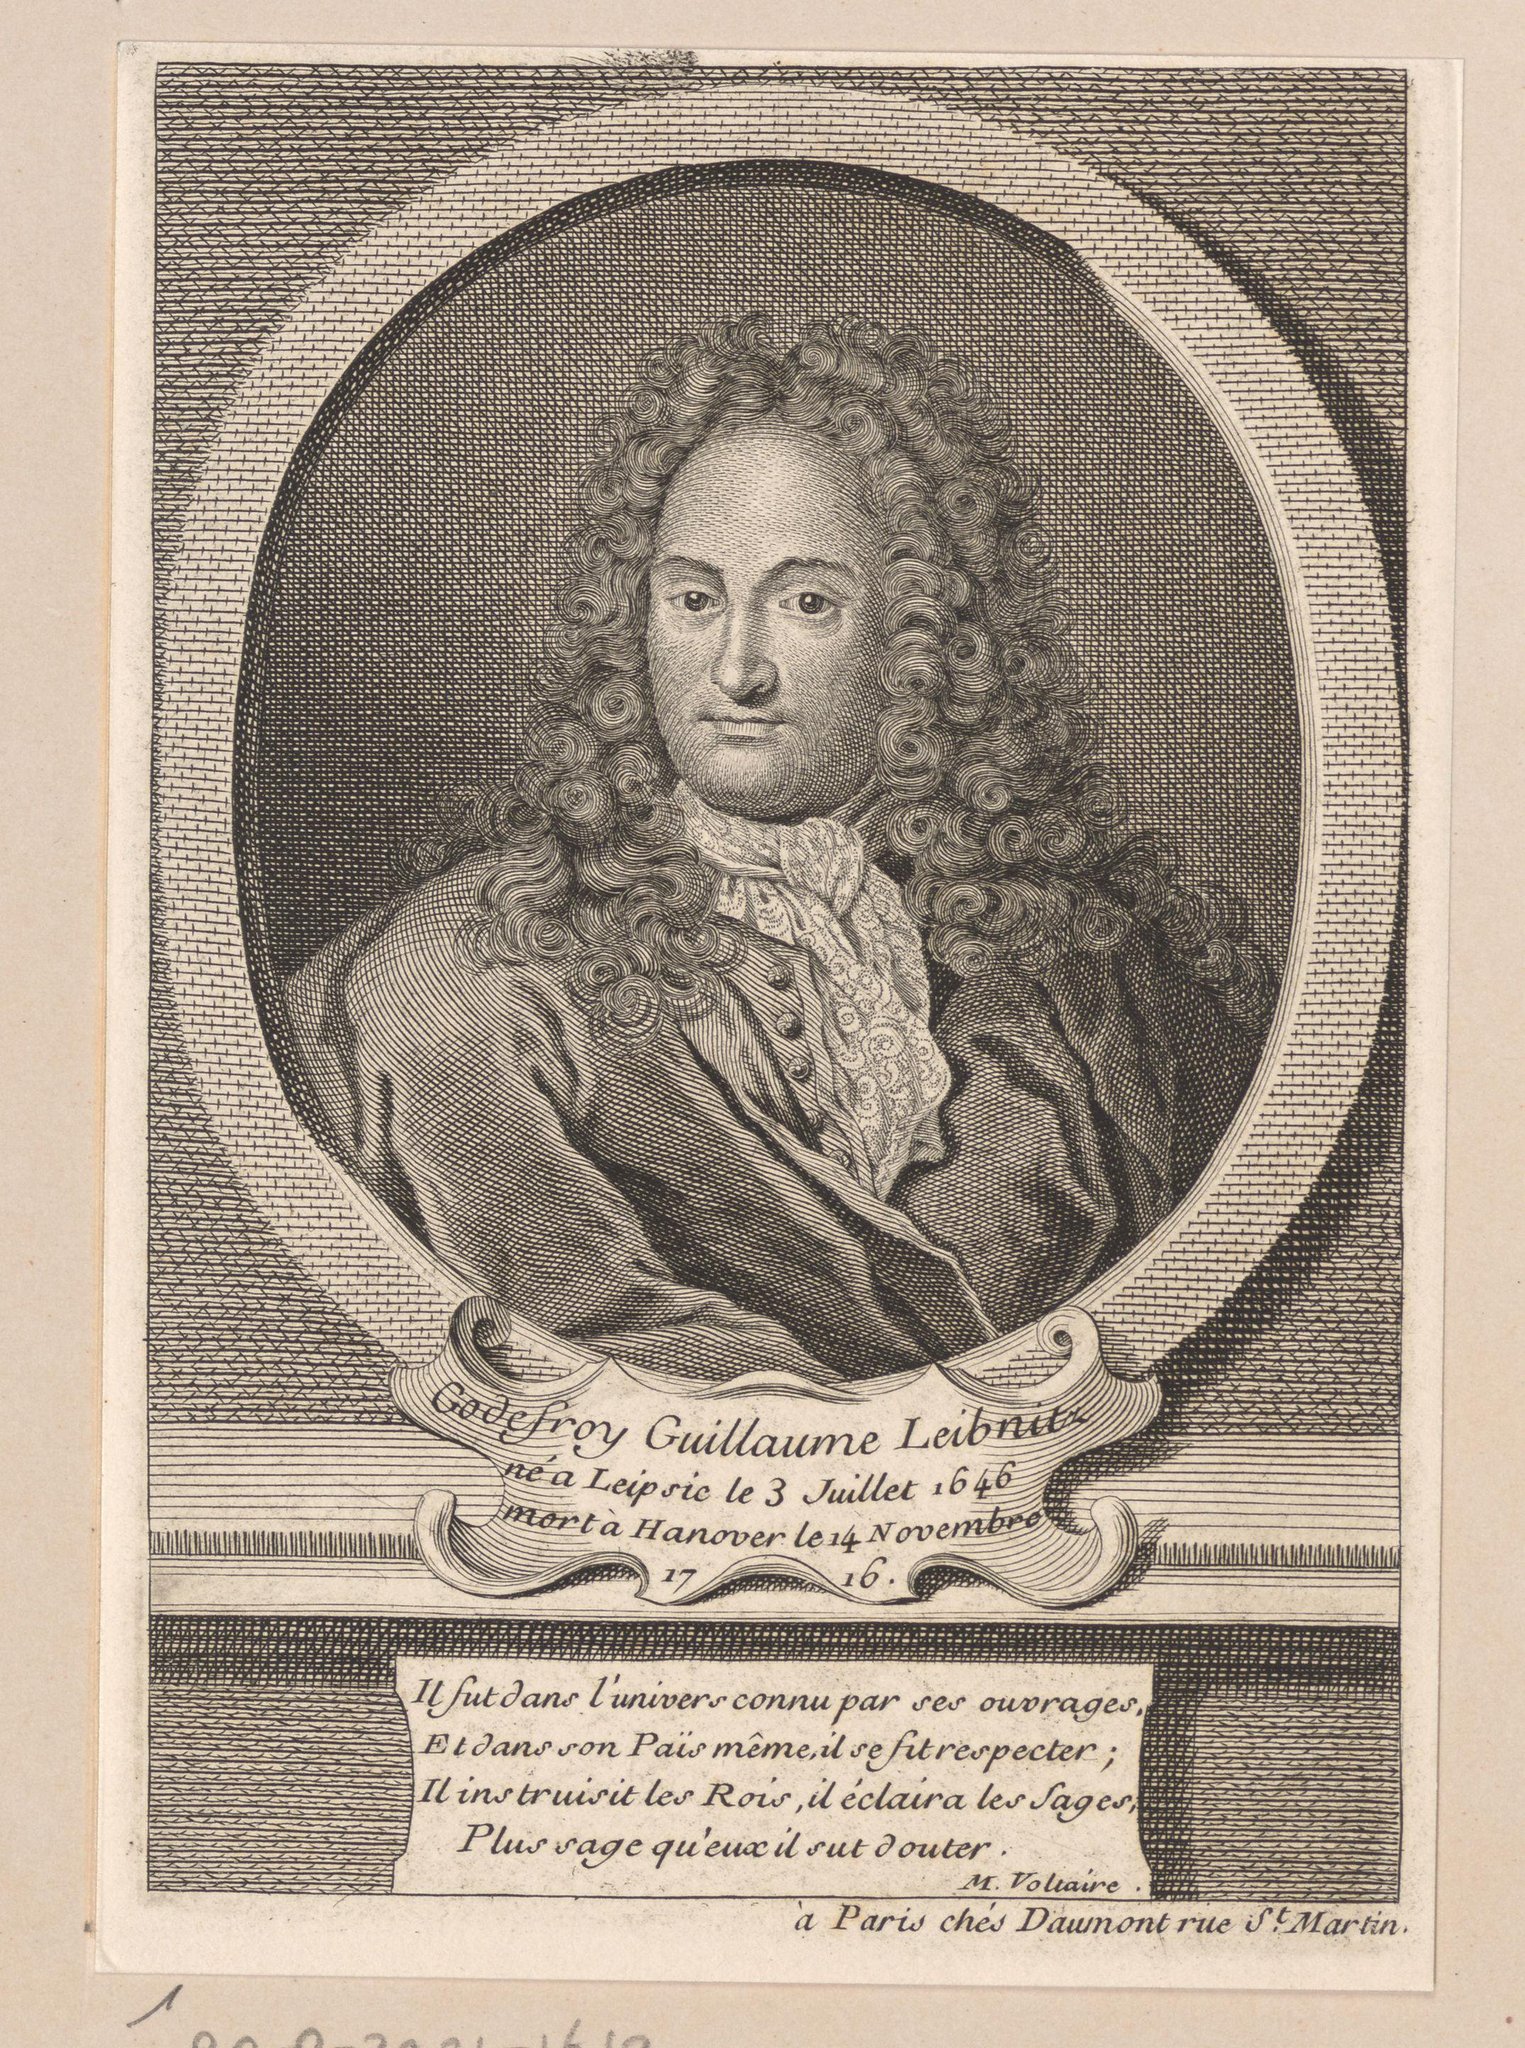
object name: print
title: Portret van Gottfried Wilhelm Leibniz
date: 1760-1775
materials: paper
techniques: engraving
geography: france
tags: ornament ~ medallion, historical persons, scholar, philosopher (+ portrait of scholar, scientist)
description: Met onderschrift en vierregelig vers in het Frans.